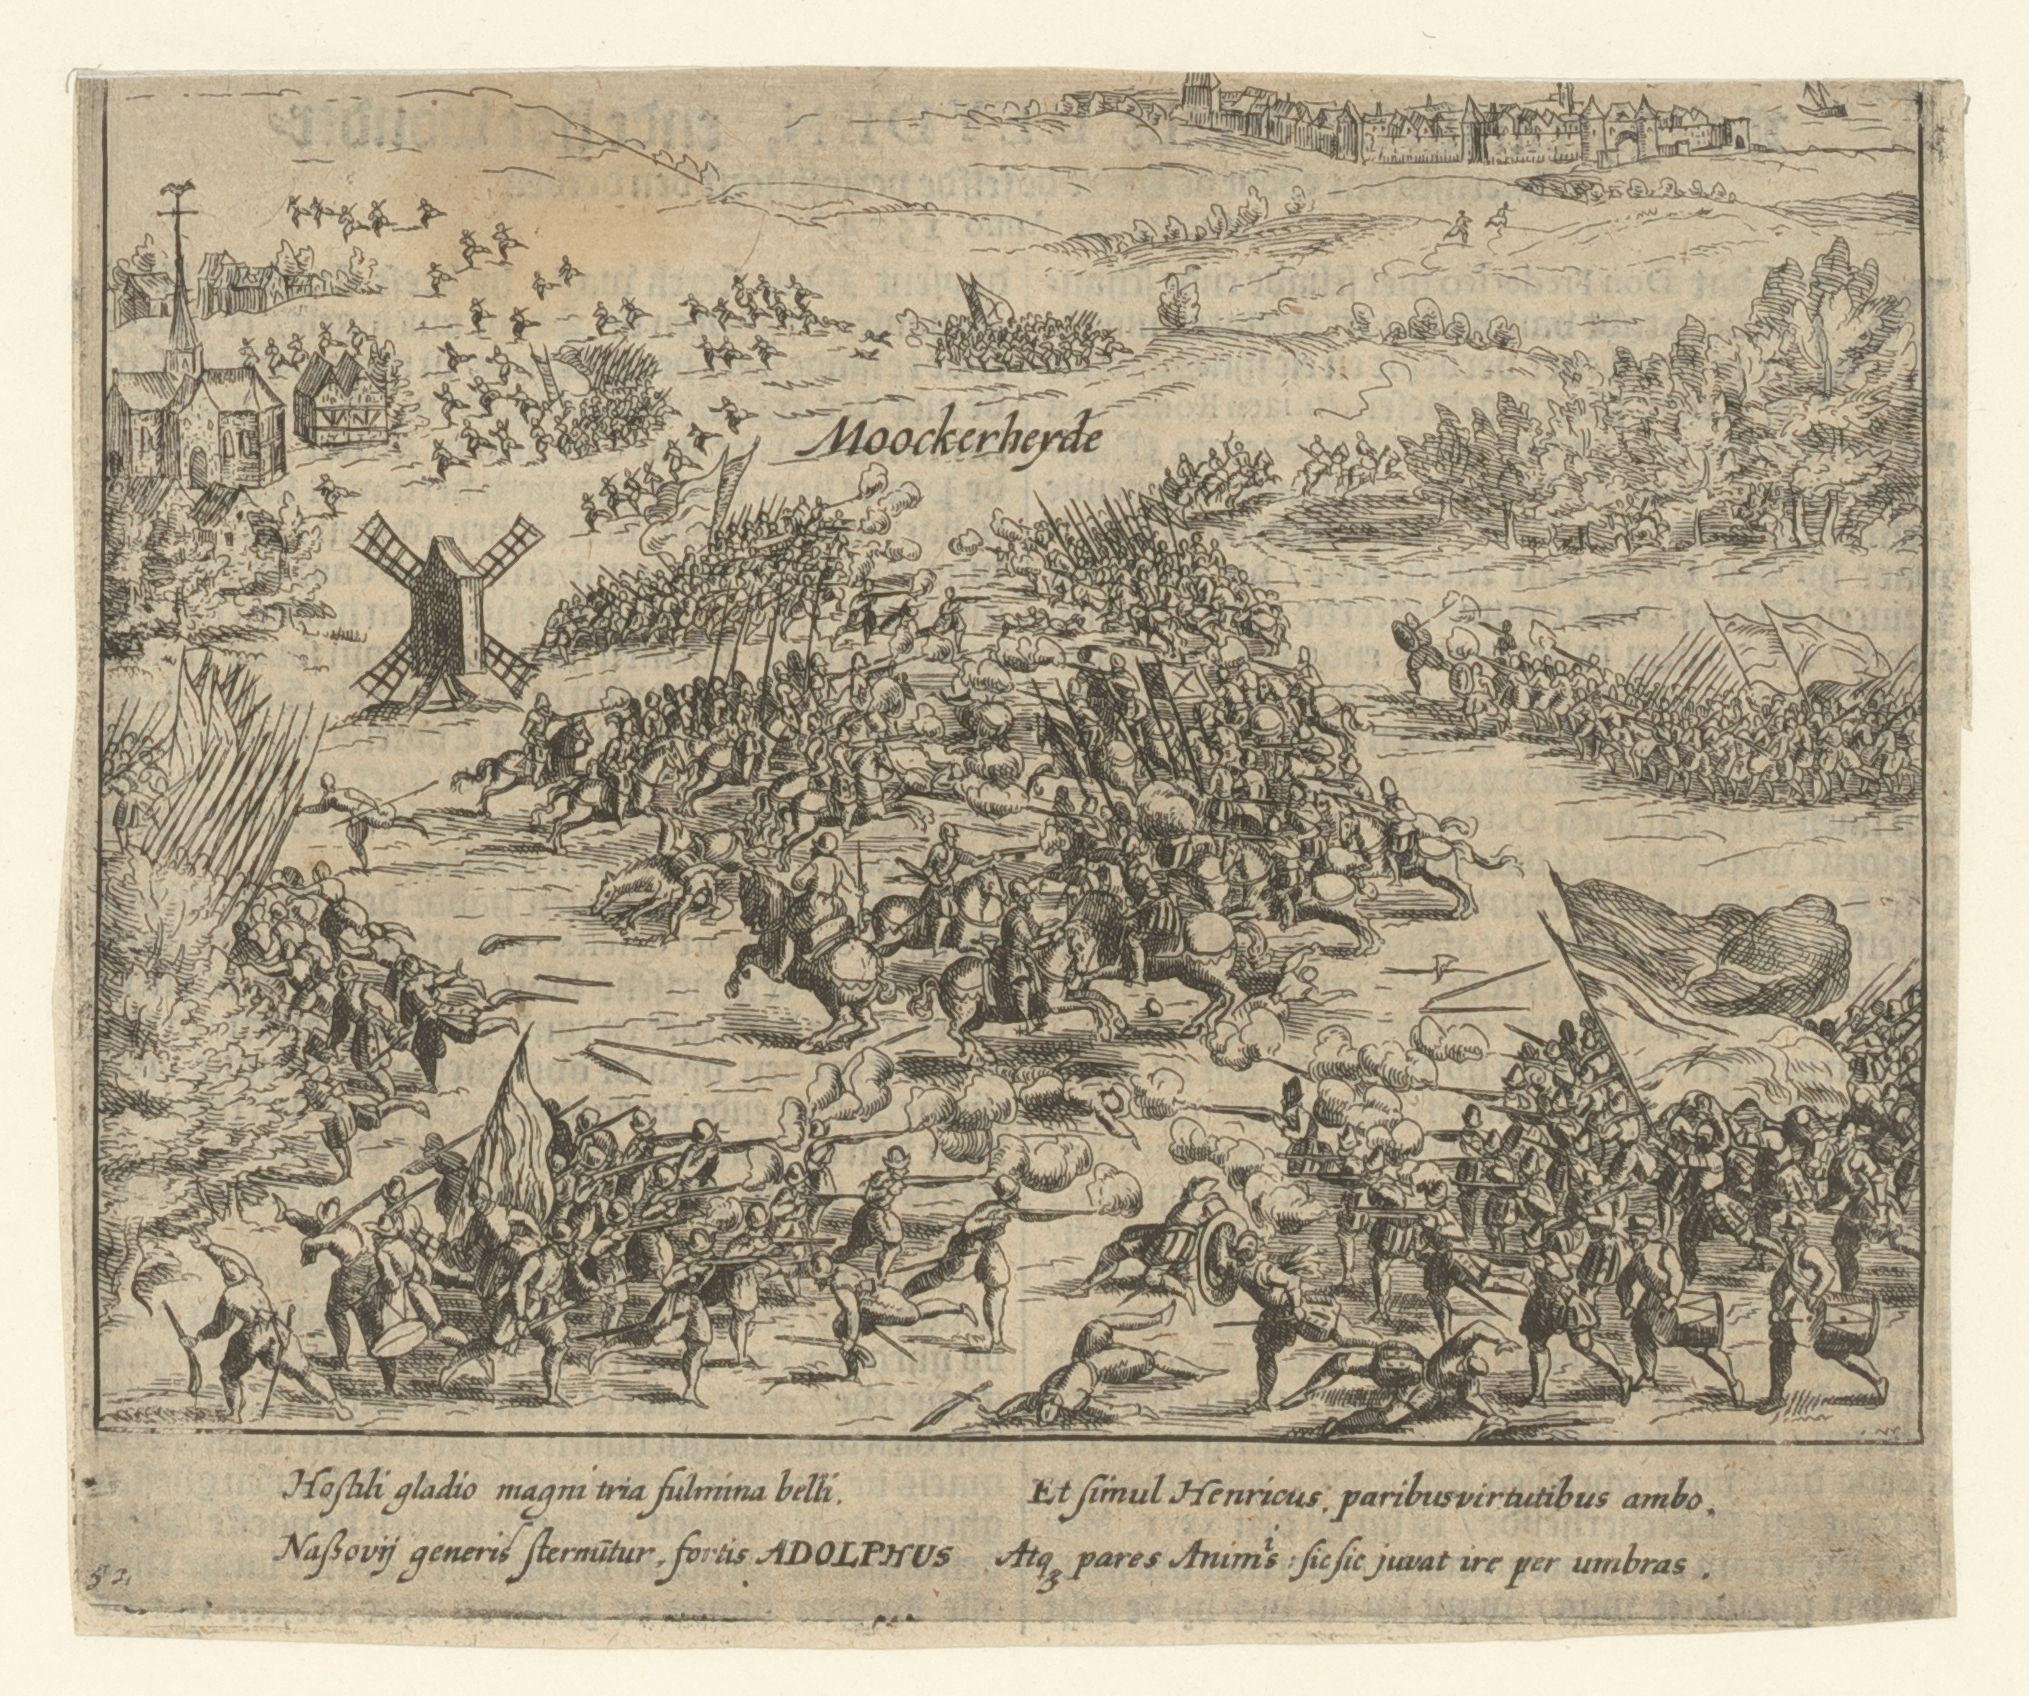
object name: book illustration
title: Slag op de Mookerheide, 1574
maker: Anonymous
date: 1613-1615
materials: paper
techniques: etching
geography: northern netherlands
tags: battle (+ land forces), nijmegen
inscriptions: collector's mark: Lugt 1641, collector's mark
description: Slag op de Mookerheide, 14 april 1574. Veldslag tussen het leger van de opstandelingen onder bevel van Lodewijk en Hendrik van Nassau en het Spaanse leger onder de veldheren d'Avila, Mendoza en Mondragon. Linksboven Nijmegen, rechts Mook. Met onderschrift van 4 regels in het Latijn. Genummerd: 52. Bedrukt op achterzijde met tekst in het Nederlands. Onderwerpsrubrieken binnen de Atlas Zeden en Gewoonten: Krijgswezen; prenten van Baudart. 80j. oorlog.